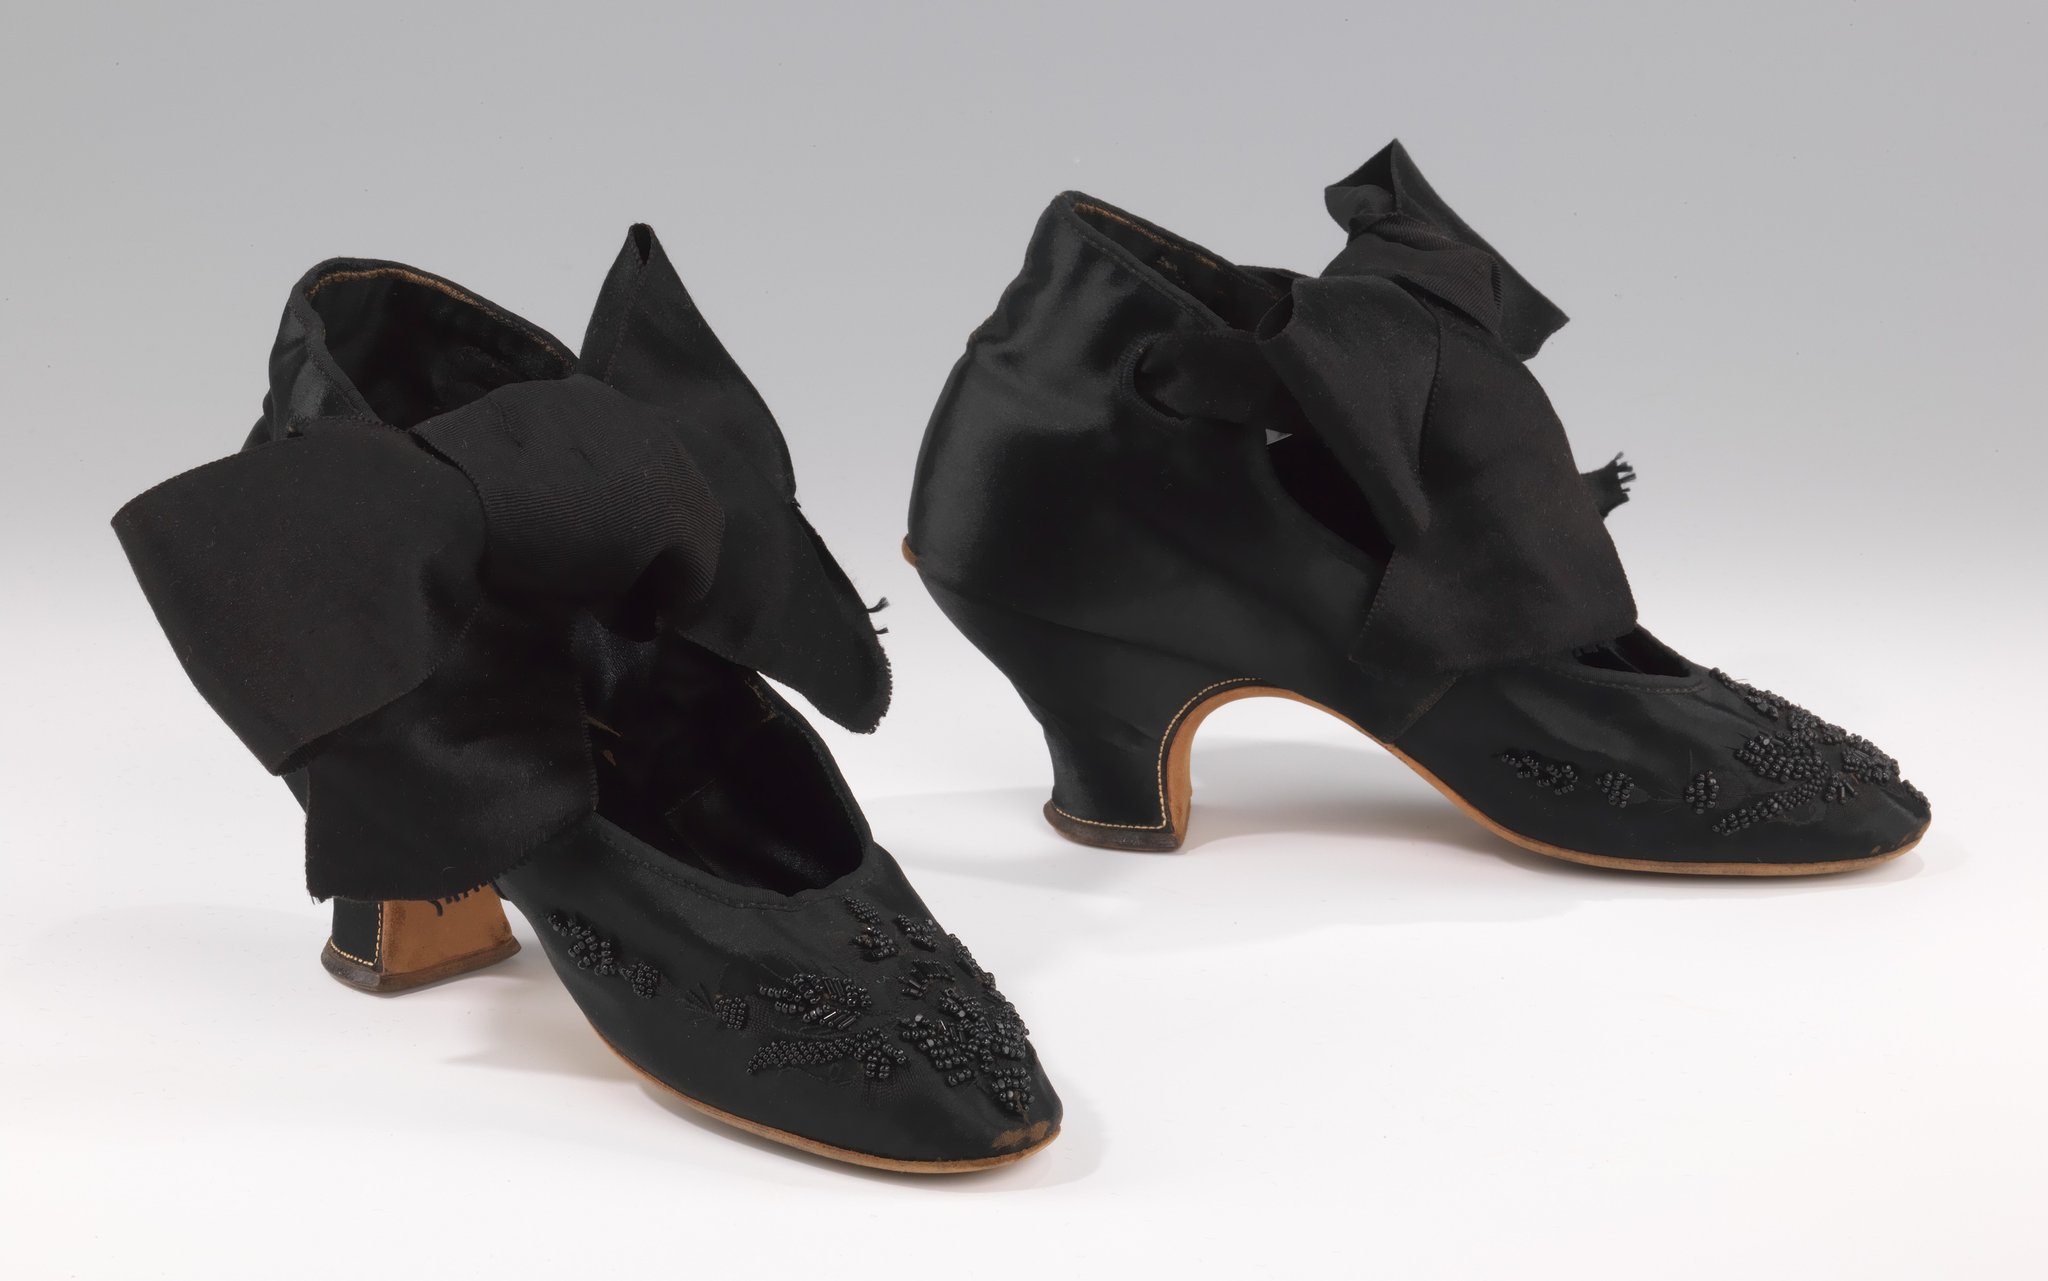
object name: evening shoe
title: Evening shoes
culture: french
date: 1875-1885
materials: glass, silk